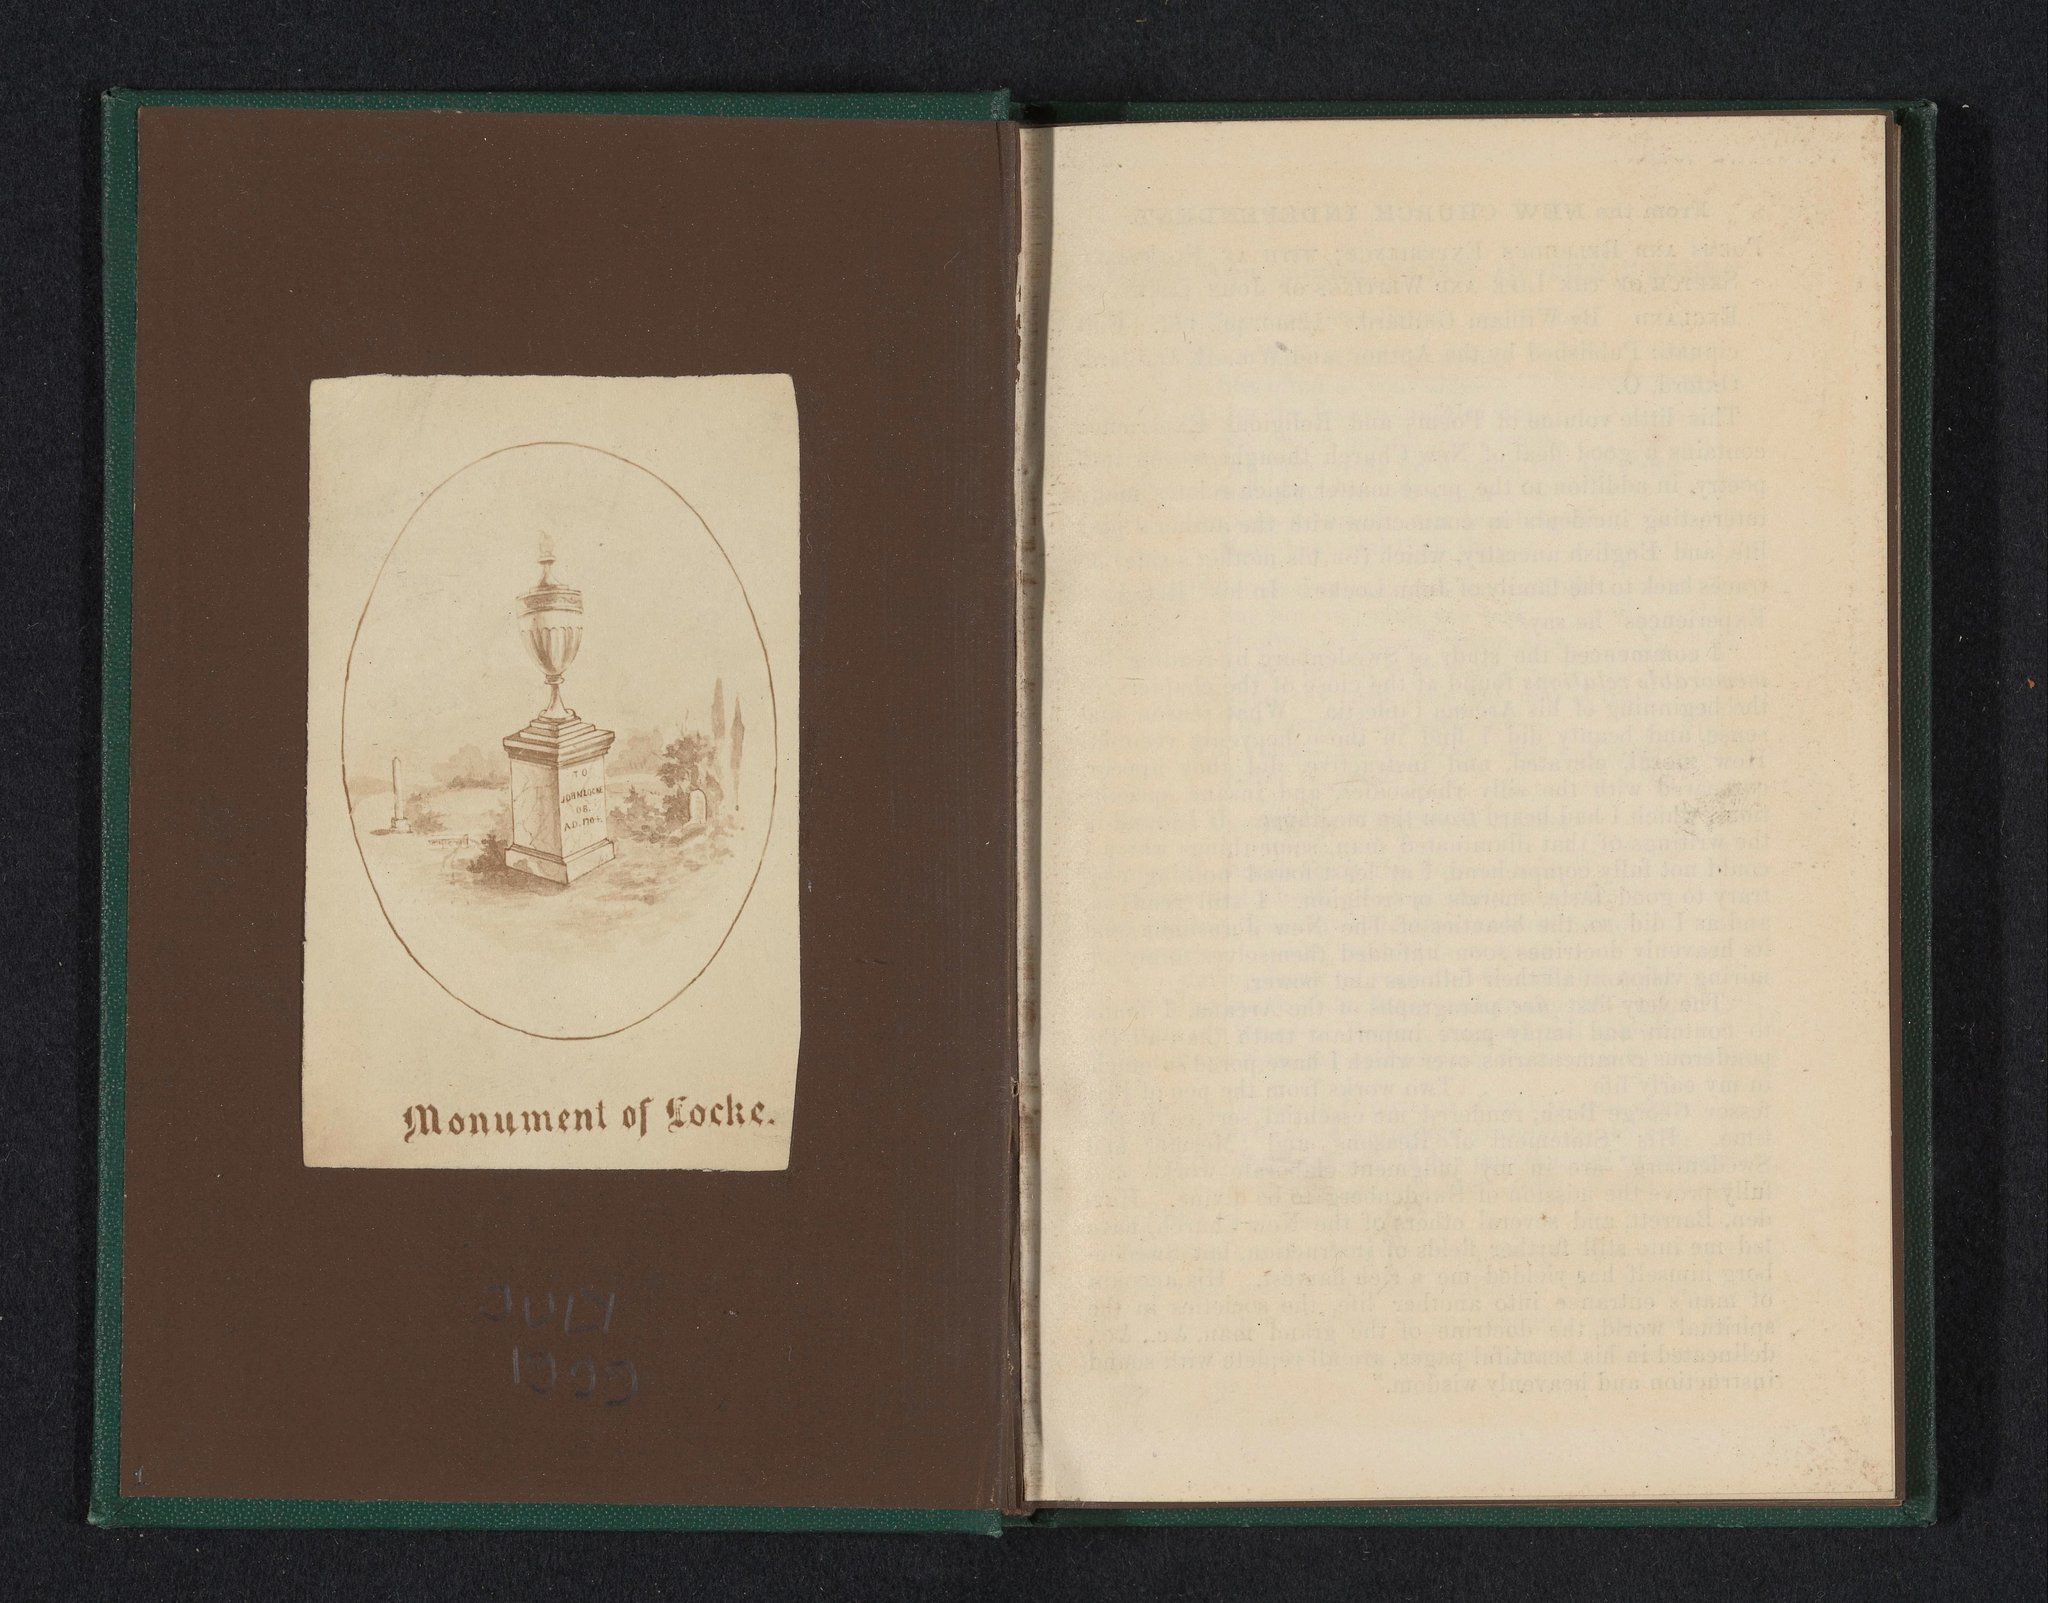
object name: reproduction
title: Fotoreproductie van een prent van een monument voor John Locke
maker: Anonymous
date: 1865-1875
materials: photographic support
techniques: albumen print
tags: politician, physicist, monument, statue